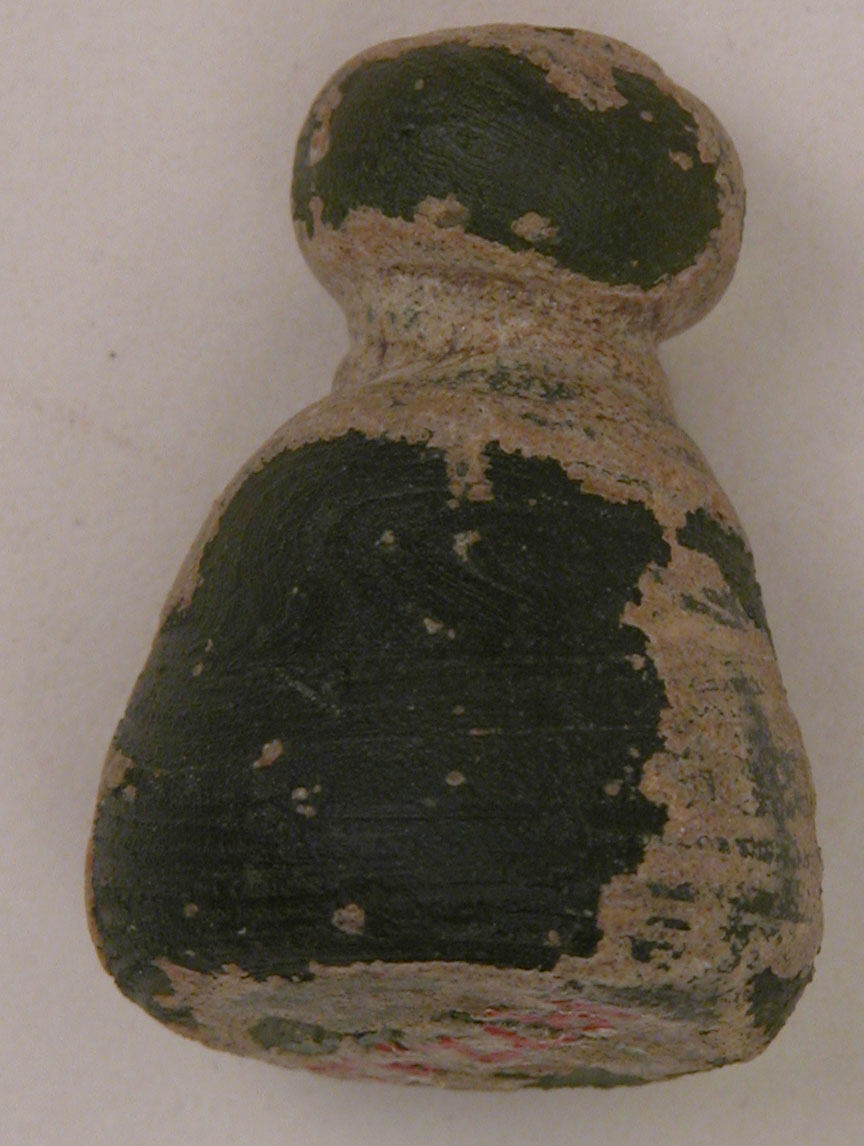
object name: chess piece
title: Chess Piece, Pawn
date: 701-1100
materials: glass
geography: western islamic lands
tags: chess